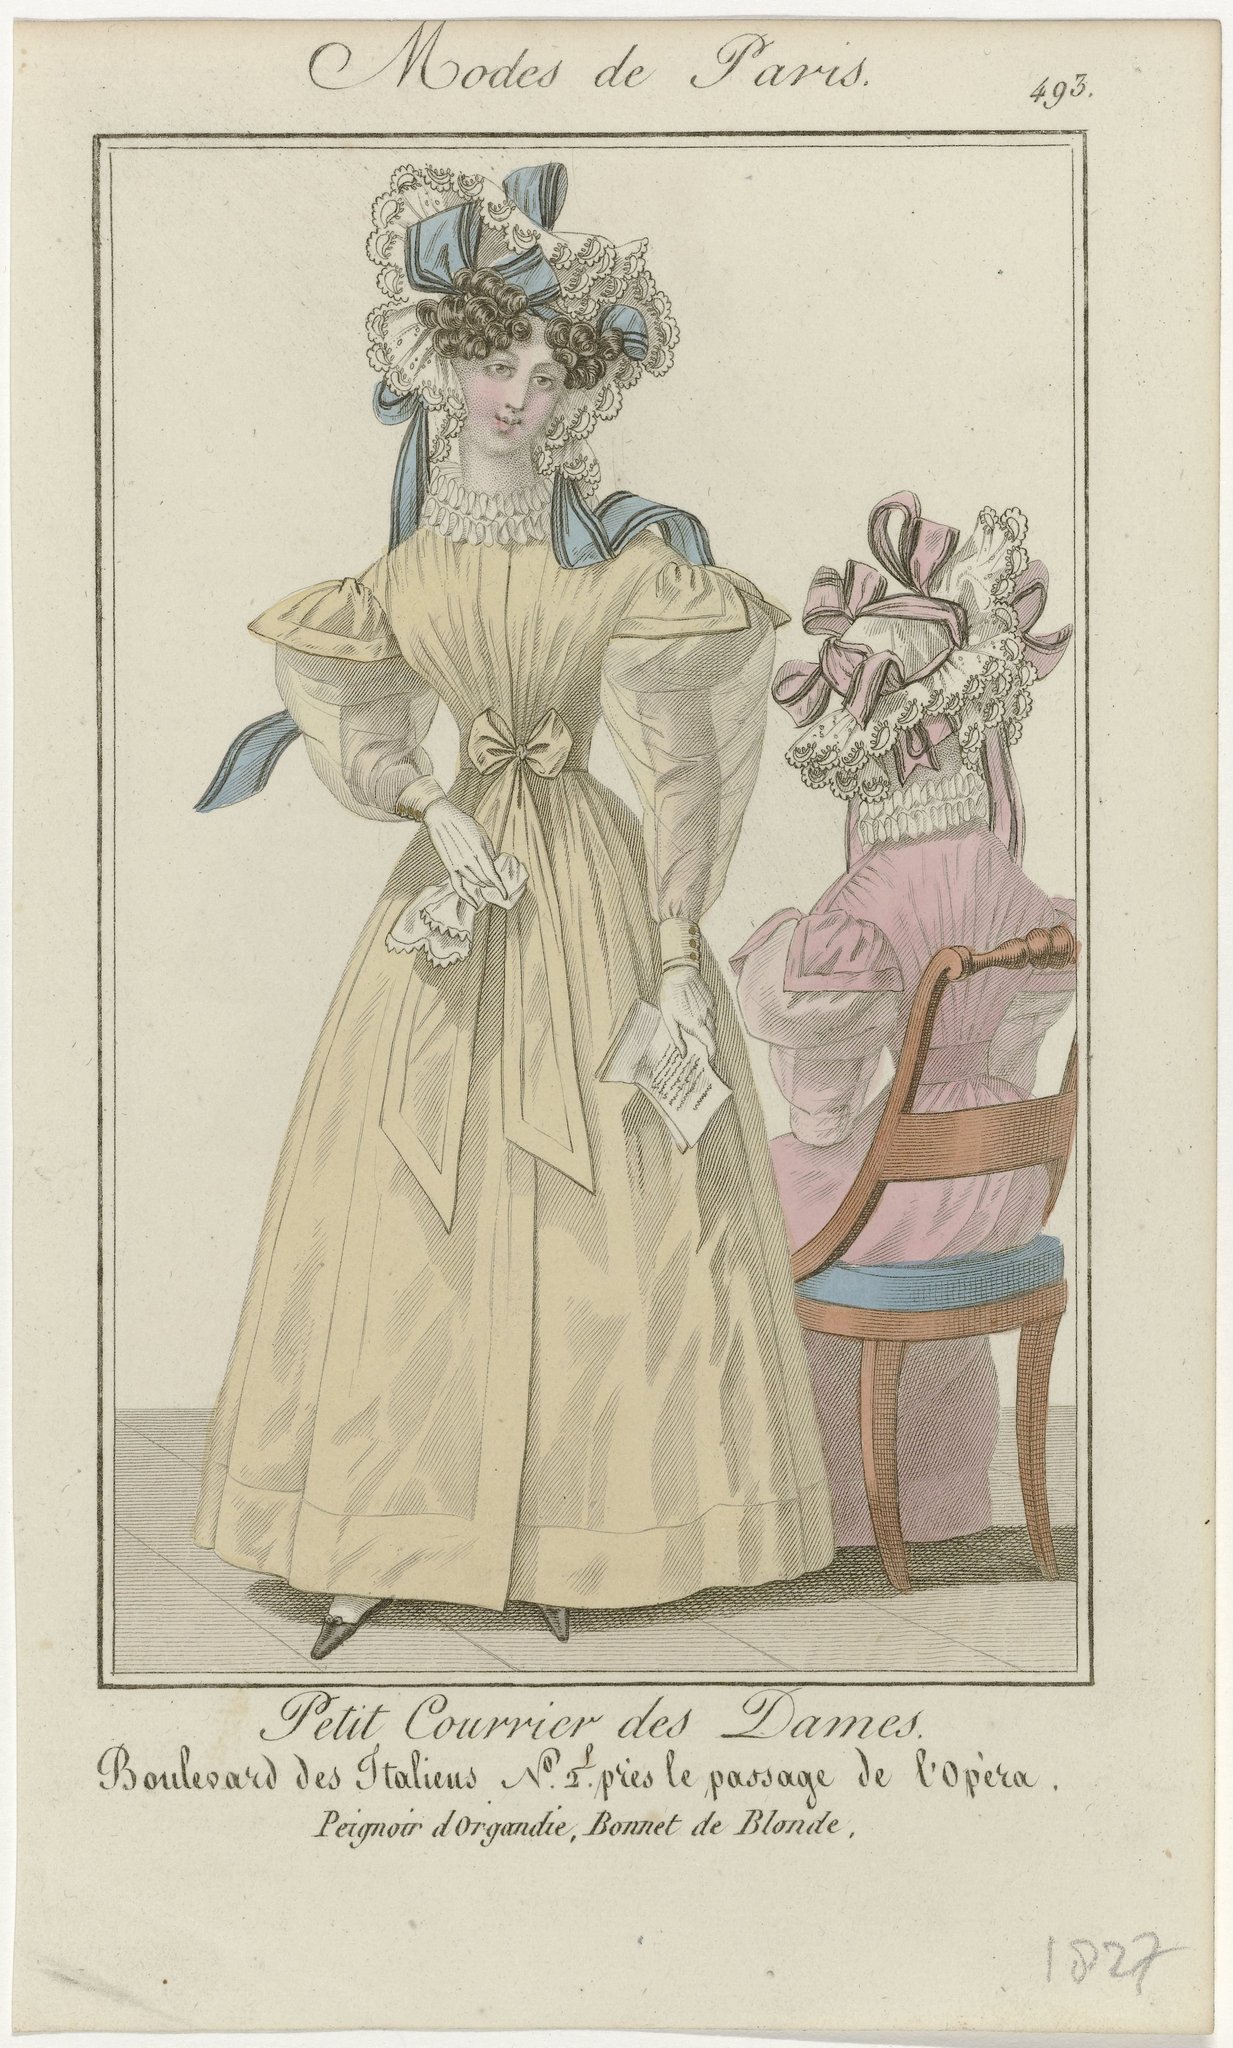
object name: fashion print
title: Petit Courrier des Dames, 1827, No. 493 : Peignoir d'Organdi (...)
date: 1827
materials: paper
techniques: engraving, hand coloring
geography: paris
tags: handkerchief (+ women's clothes), coat (housecoat) (+ women's clothes), head-gear: cap (+ women's clothes), fashion plates, shoes, sandals (+ women's clothes), gloves, mittens, etc. (+ women's clothes), letter, envelope, neck-gear ~ clothing (+ women's clothes)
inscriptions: caption: ‘Peignoir d'Organdie, Bonnet de Blonde.’, title: ‘Modes de Paris.’, title: ‘Petit Courrier des Dames.’, address: ‘Boulevard des Italiens No.2 près le passage de l'Opera.’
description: 'Peignoir' van organdie; muts van Blonde (kloskant). Verdere accessoires: handschoenen, zakdoek, platte schoenen met puntige neuzen en strikken. Prent uit het modetijdschrift Petit Courrier des Dames (1821-1868). De prent is gekopieerd in Echo 1827, La Belle Assemblée Octobre 1827.